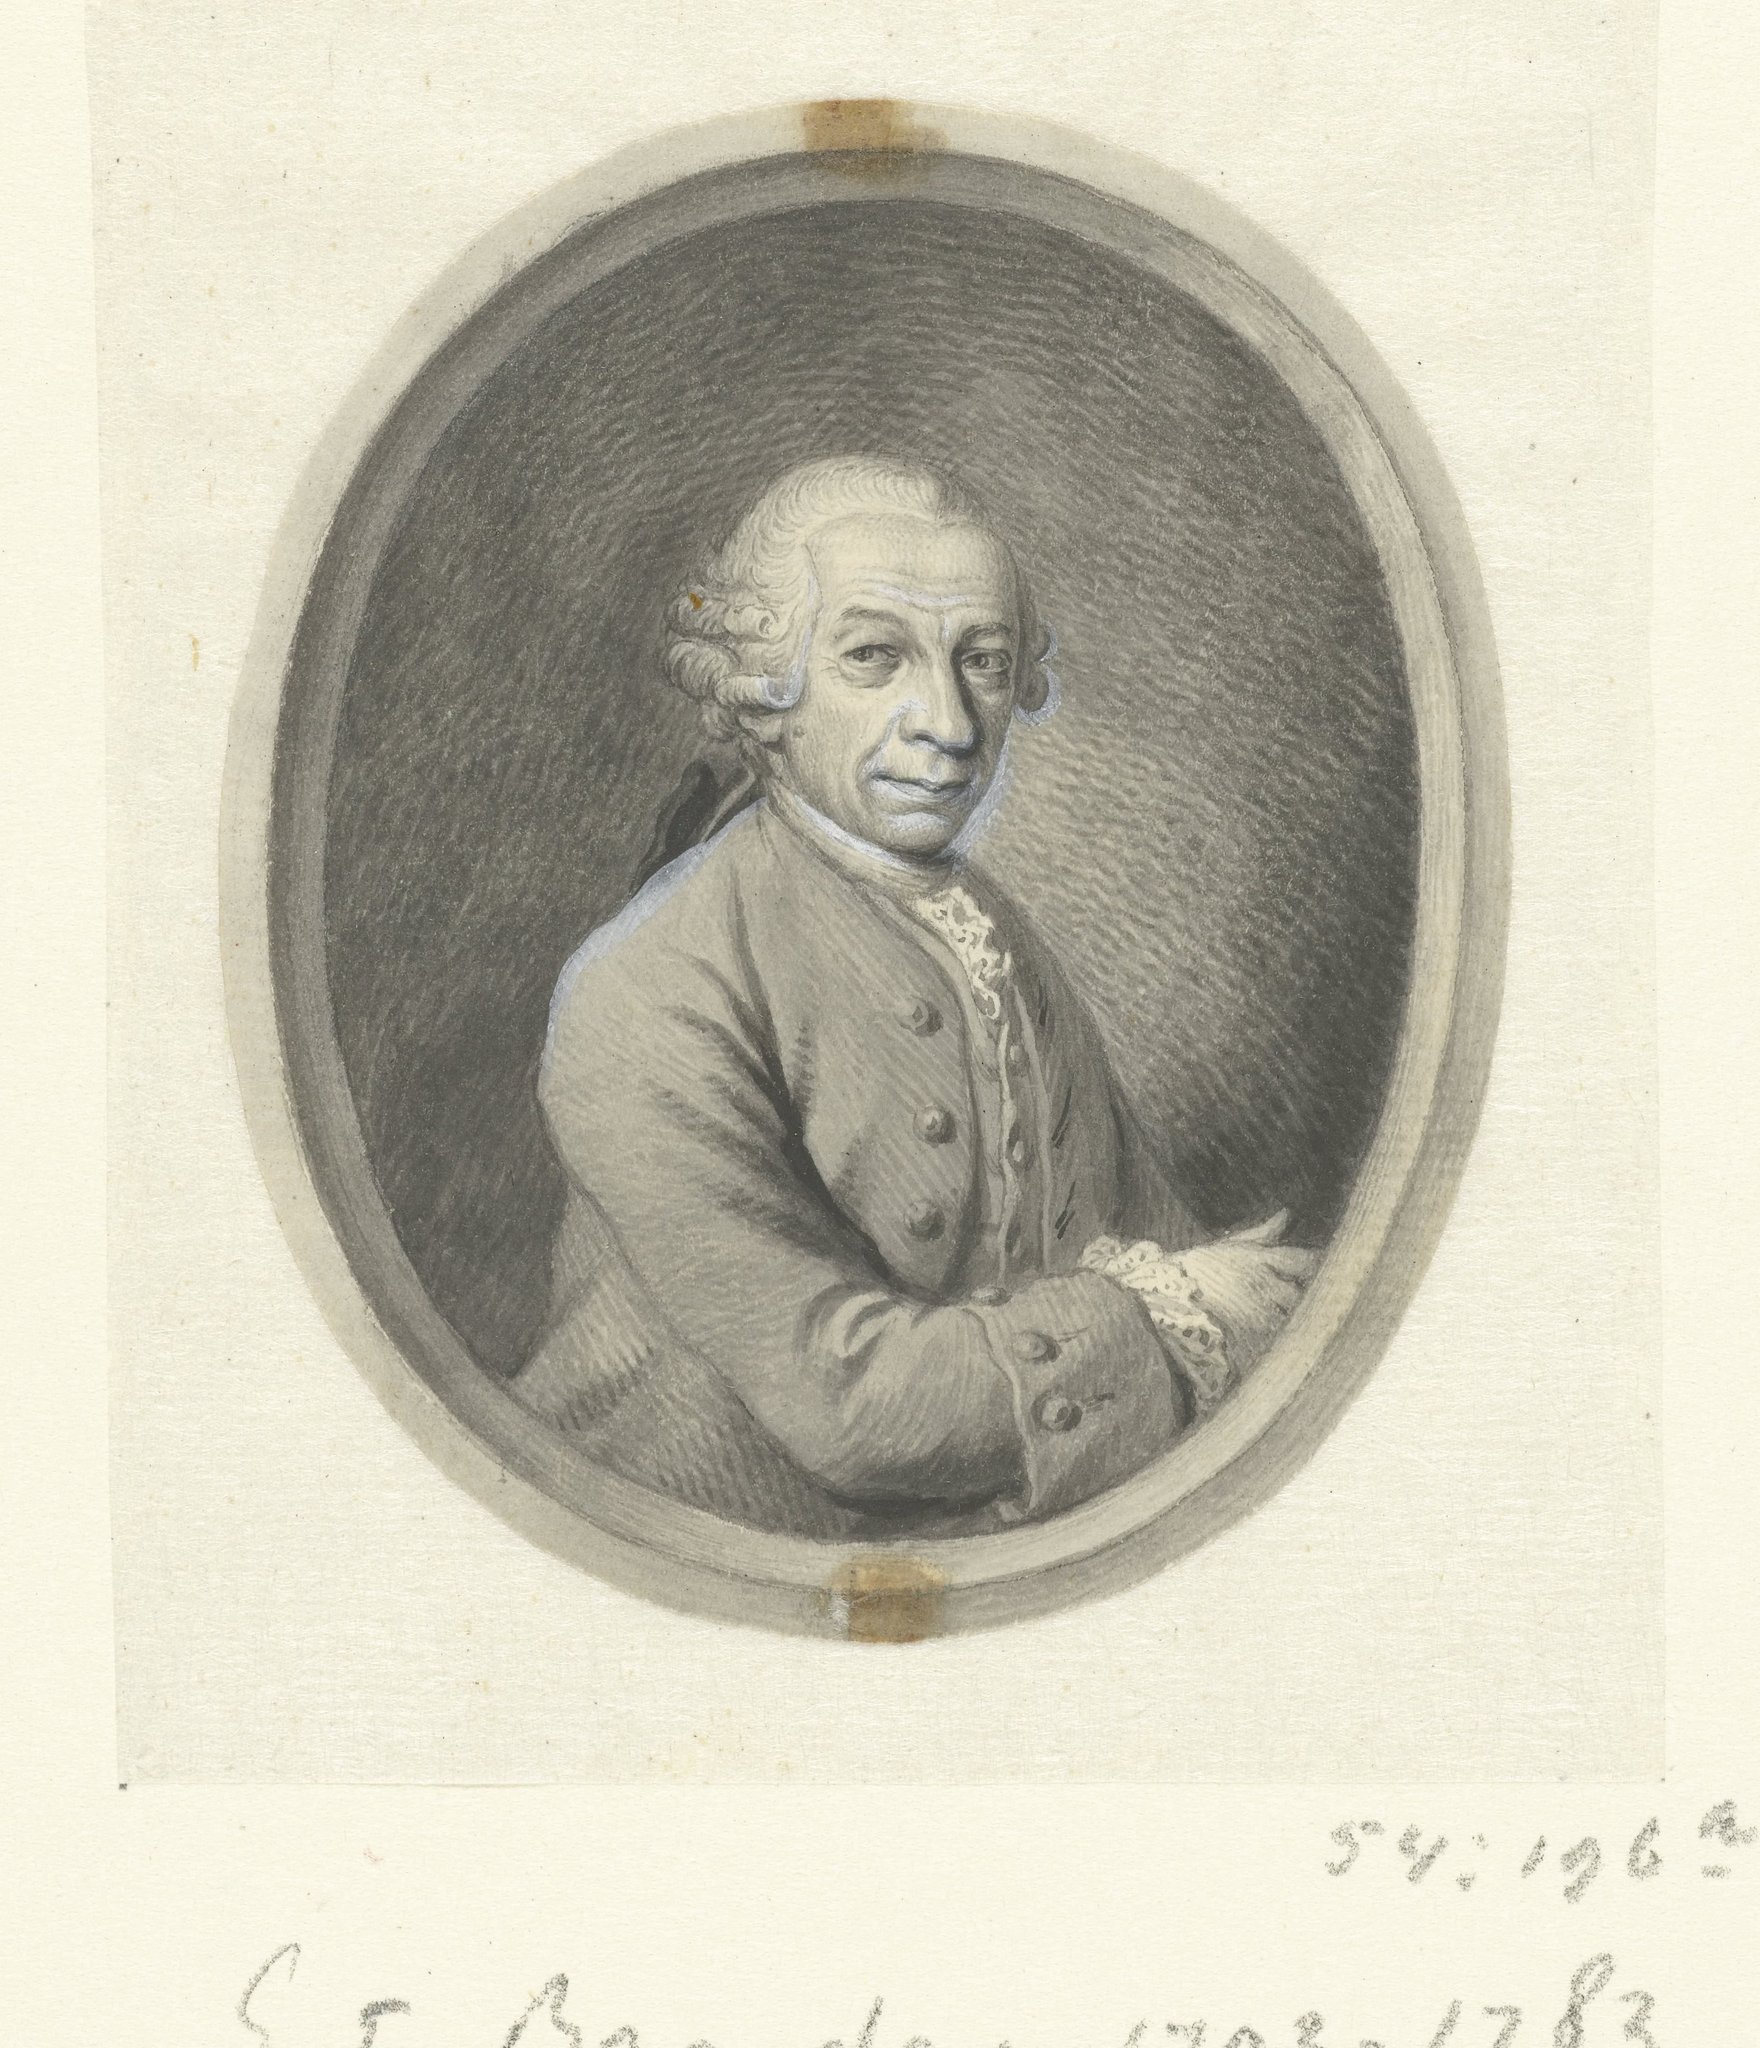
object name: design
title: Omlijsting voor portret van Georg Friedrich Brander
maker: johann esaias nilson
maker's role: draughtsman, print maker, publisher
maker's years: 1721-1788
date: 1769-1774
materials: chalk, paper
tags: instrument maker, historical persons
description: De omlijsting voor het bijbehorend portret van Georg Friedrich Brander (inv. nr. RP-T-1954-196B).